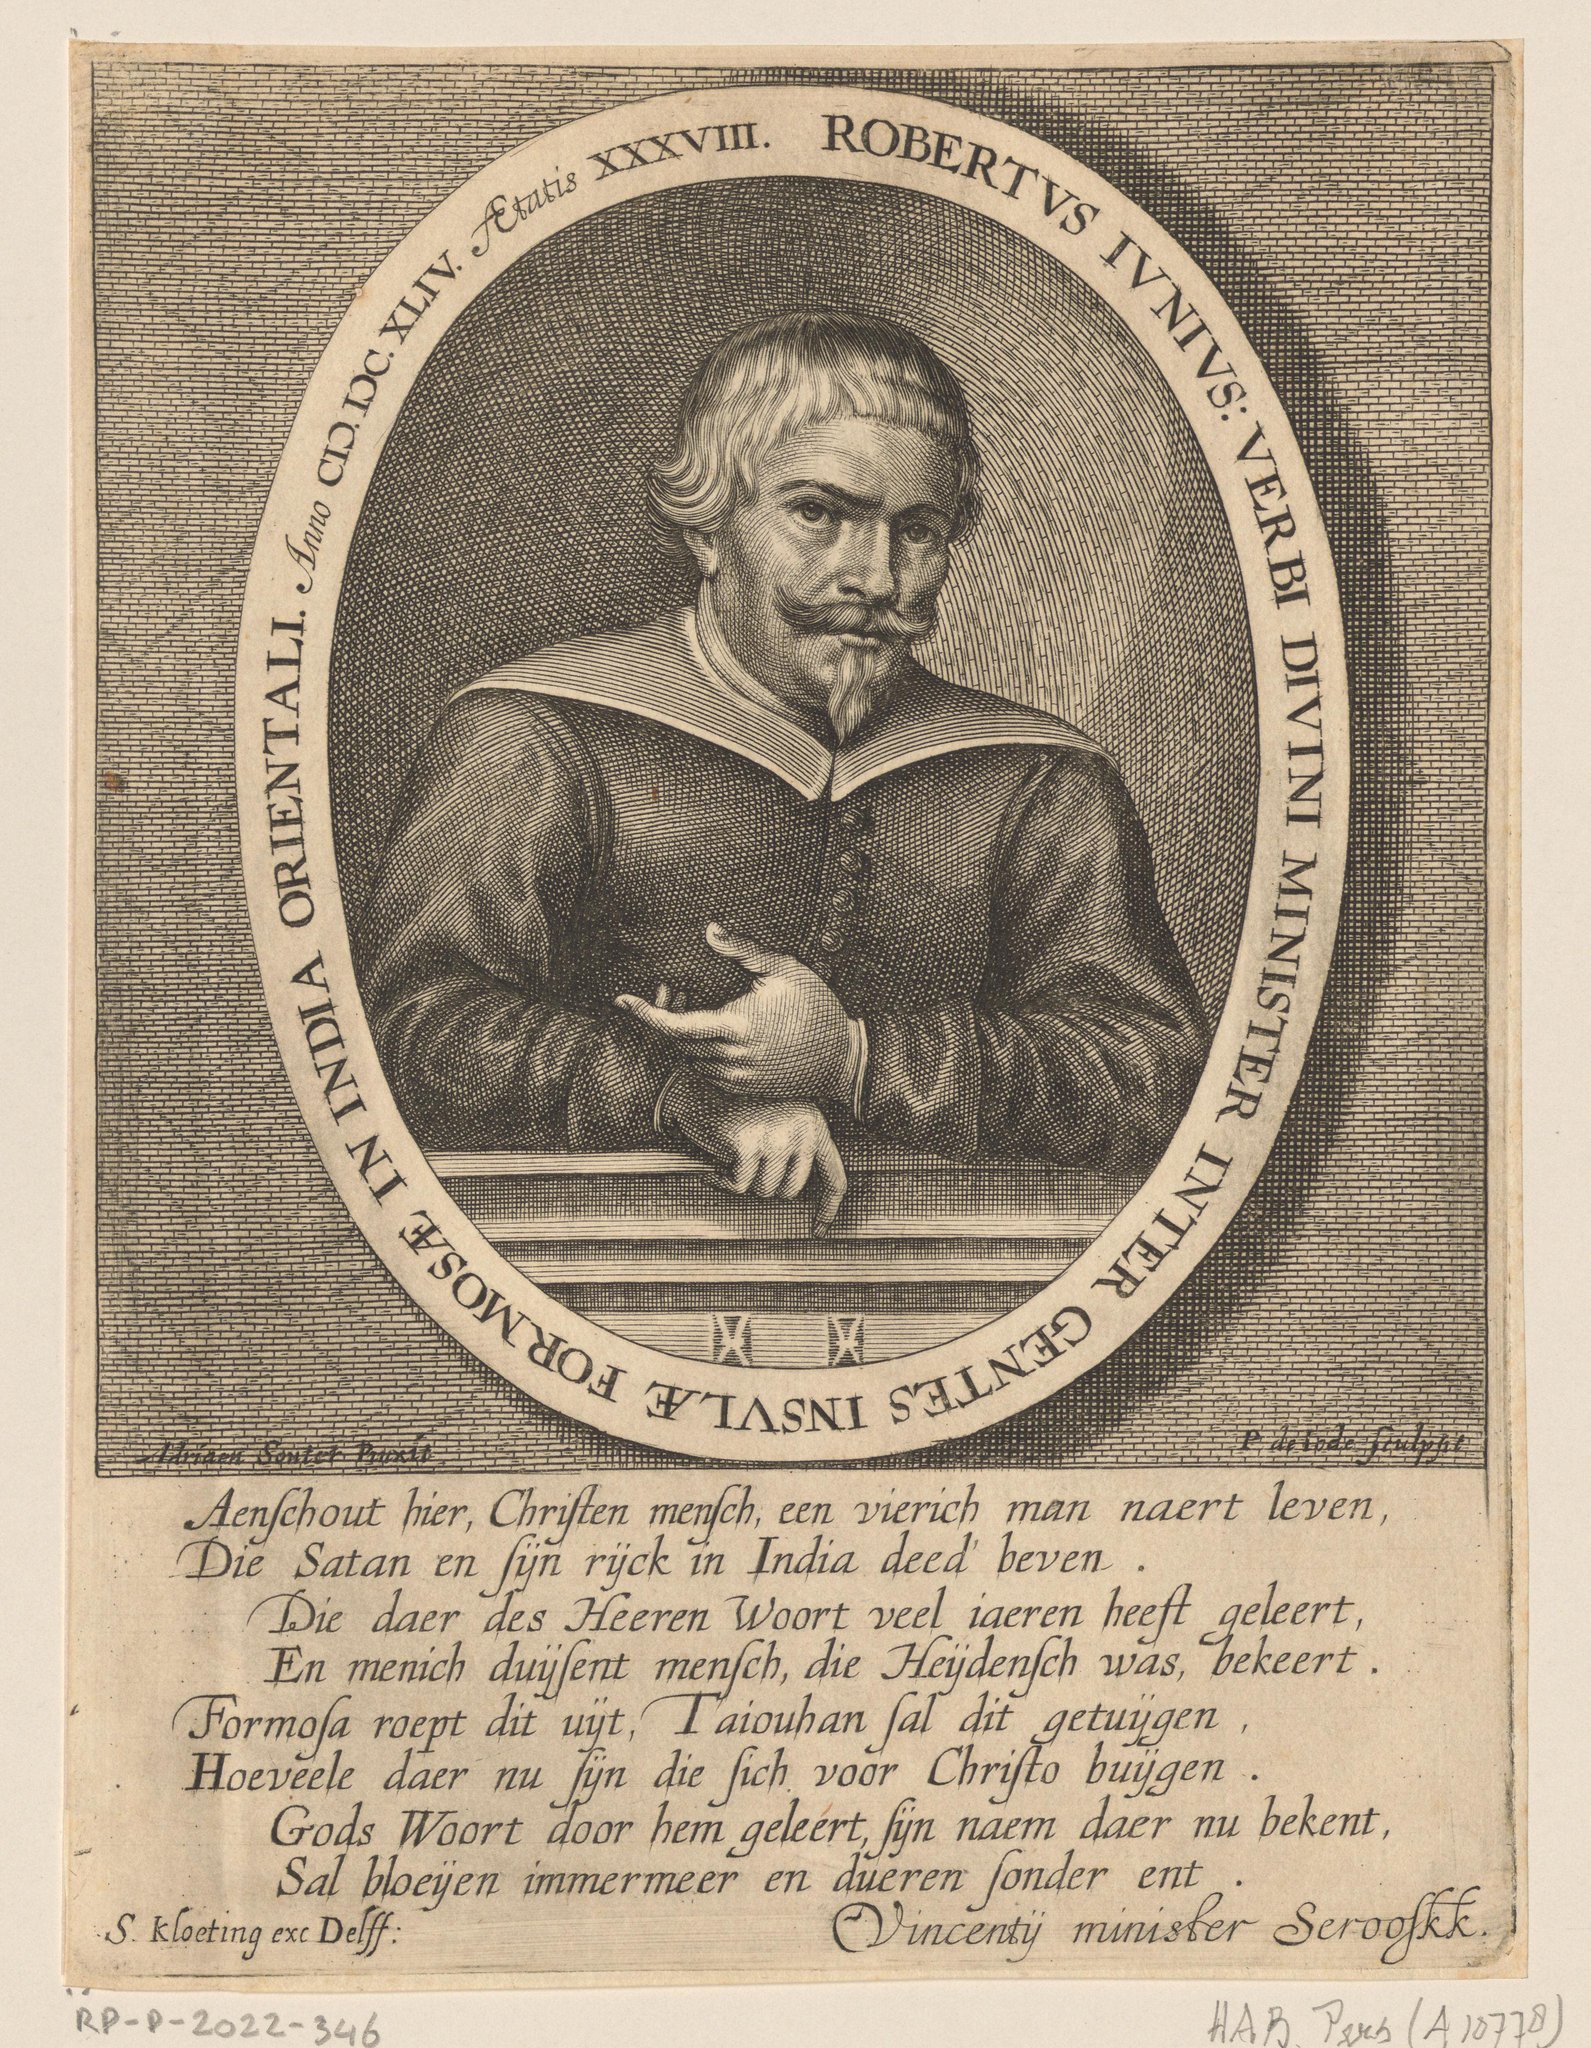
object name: print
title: Portret van Robert Junius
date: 1628-1670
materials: paper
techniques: engraving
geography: delft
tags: amsterdam, theologian, historical persons